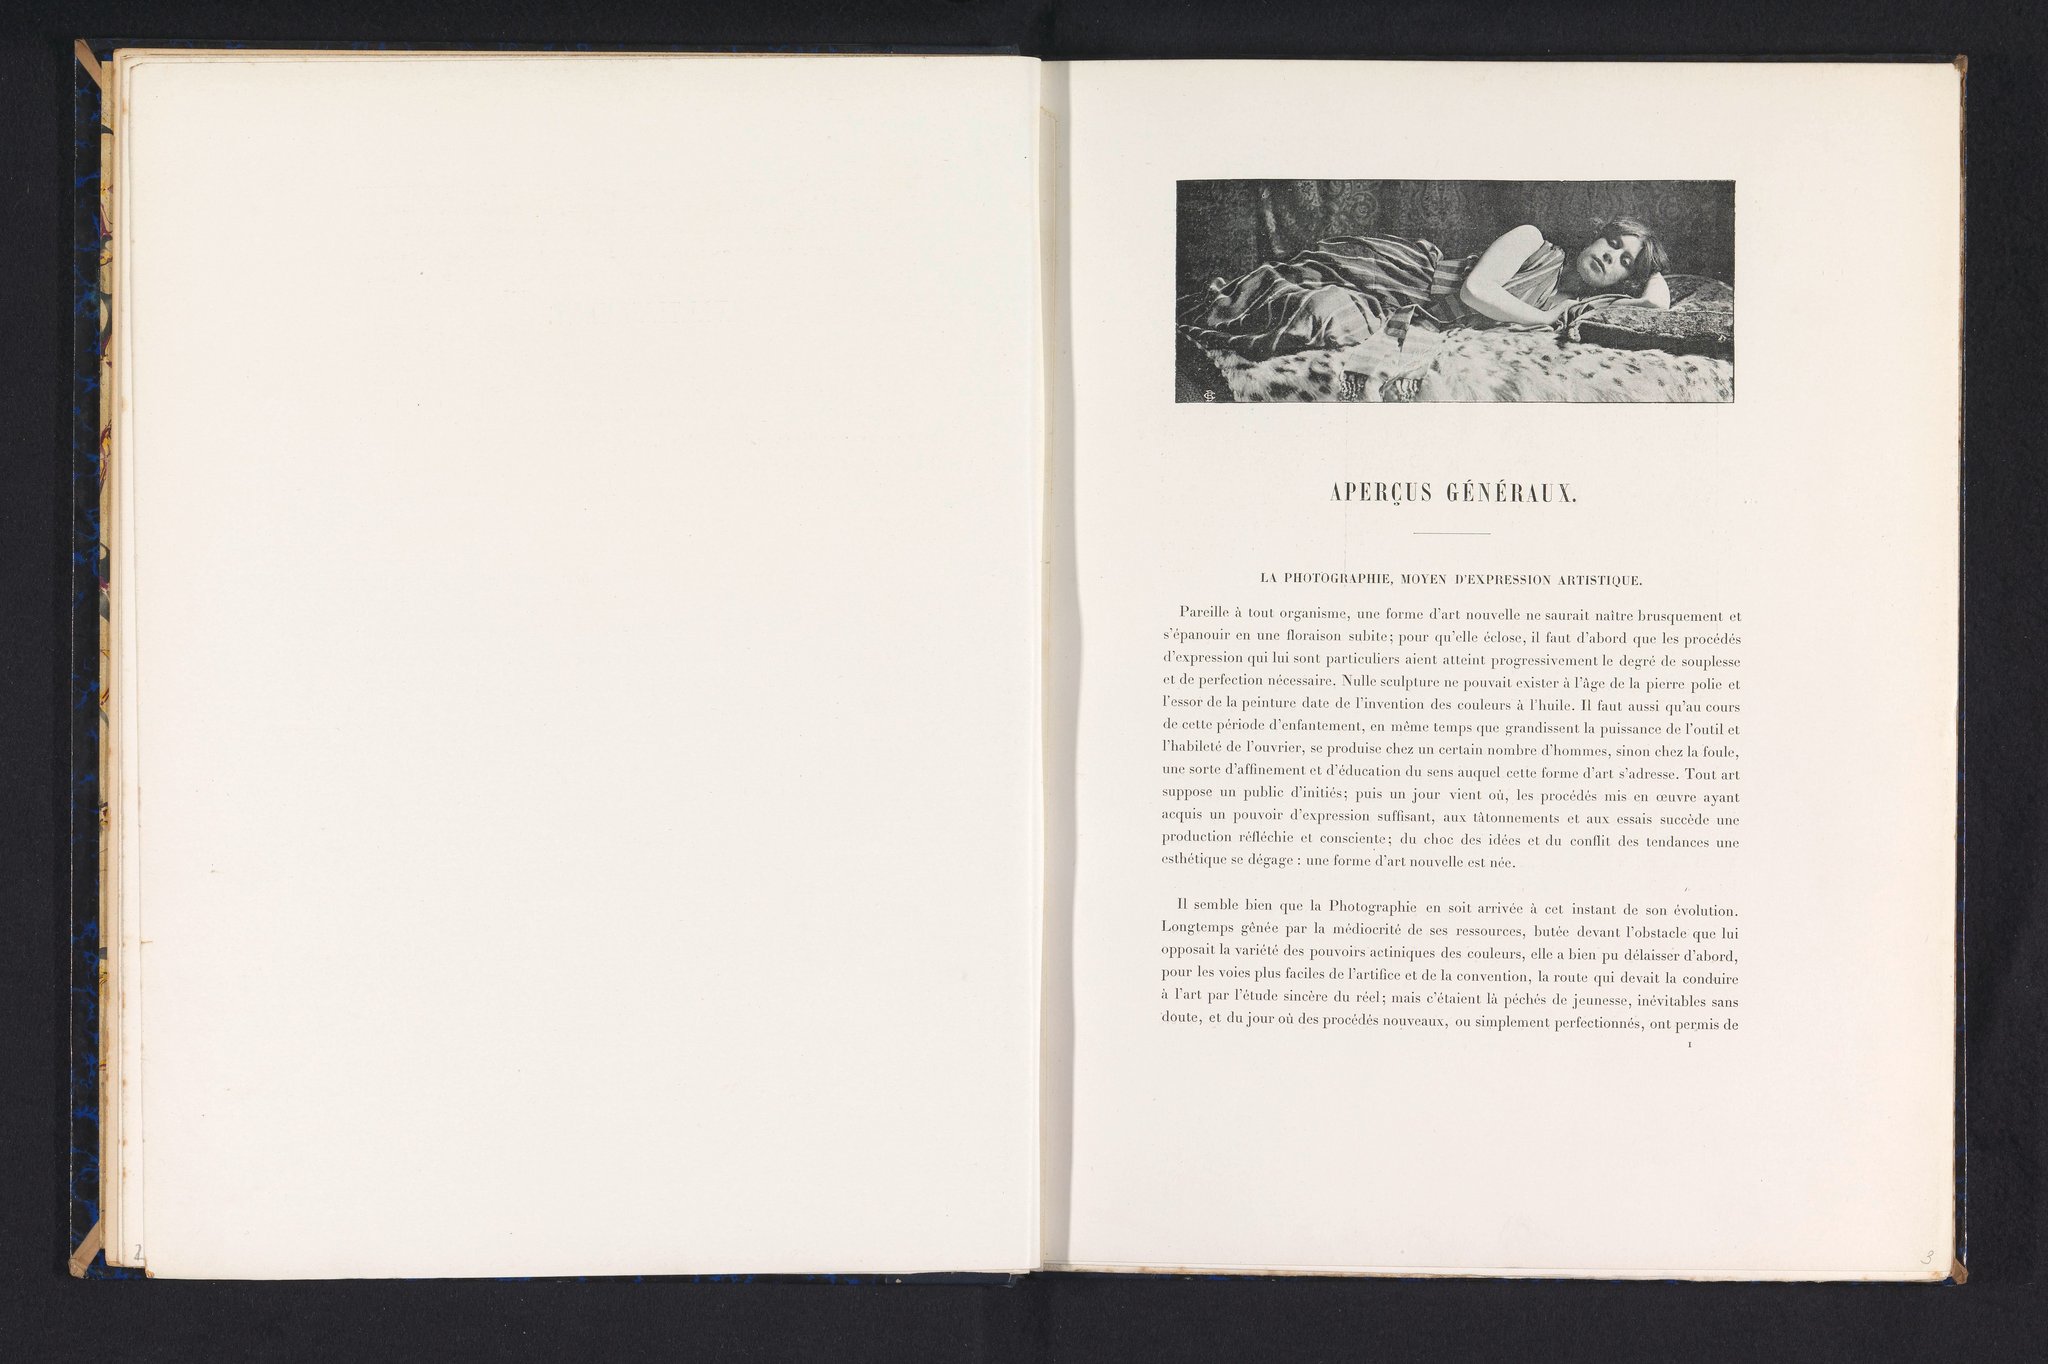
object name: page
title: Liggende vrouw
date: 1886-1896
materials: paper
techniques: autotype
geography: france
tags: lying on one side, stretched out - aa - female human figure